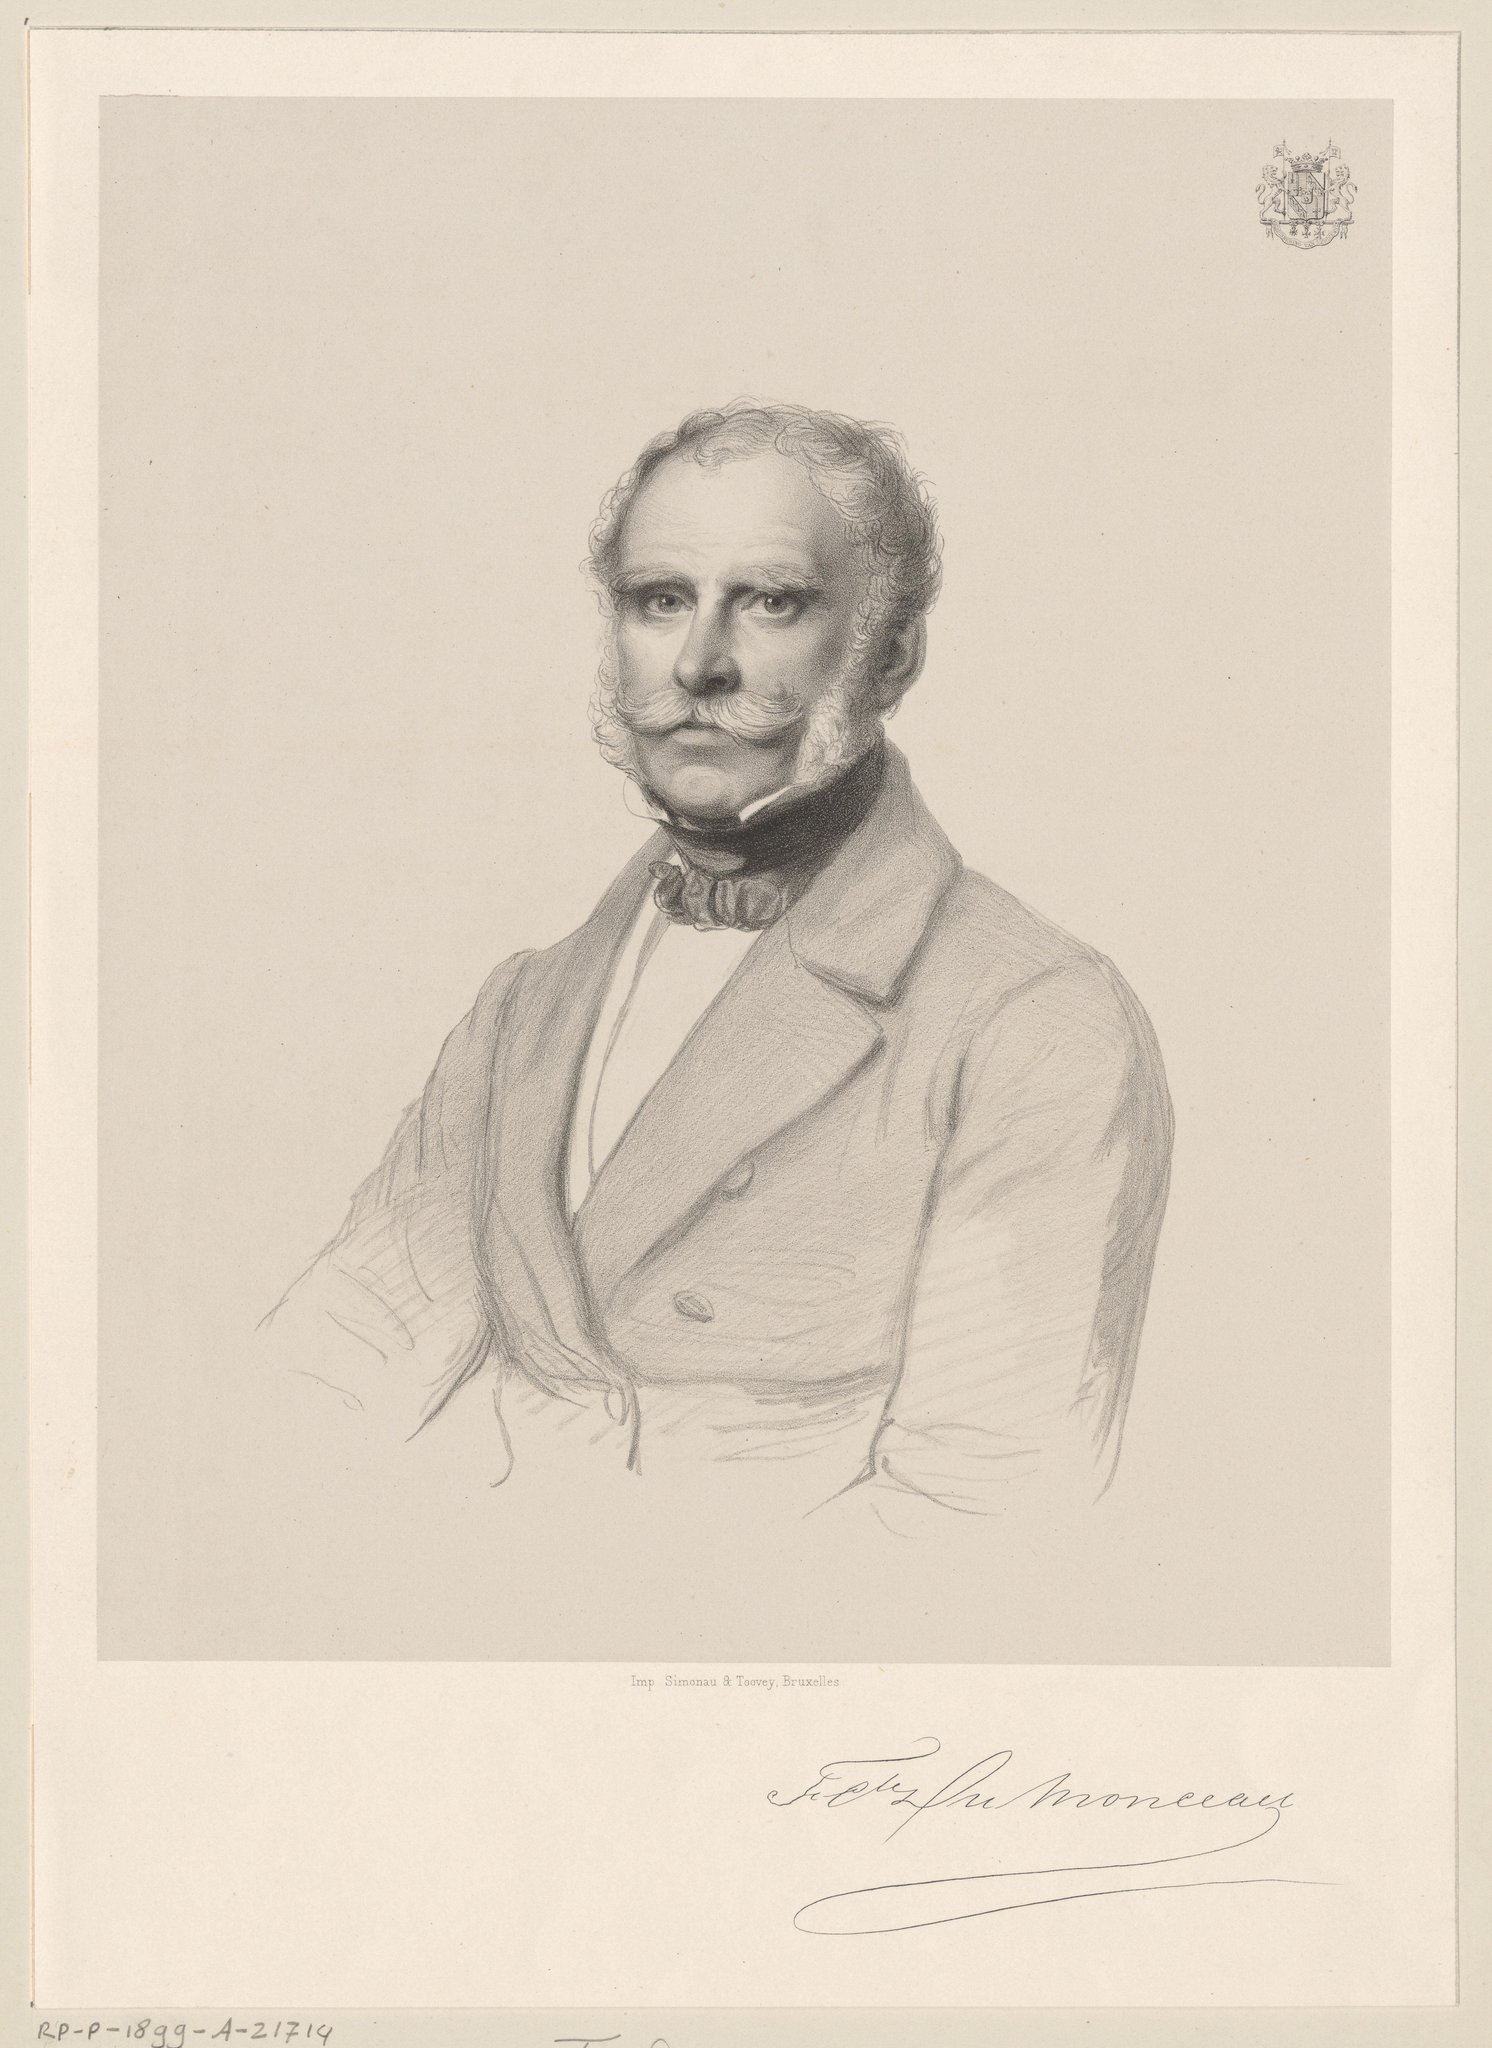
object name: print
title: Portret van graaf Jean Francois Dumonceau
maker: Anonymous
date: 1847-1875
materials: paper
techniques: lithograph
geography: brussels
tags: brussels, the hague, commander-in-chief, general, marshal, historical persons